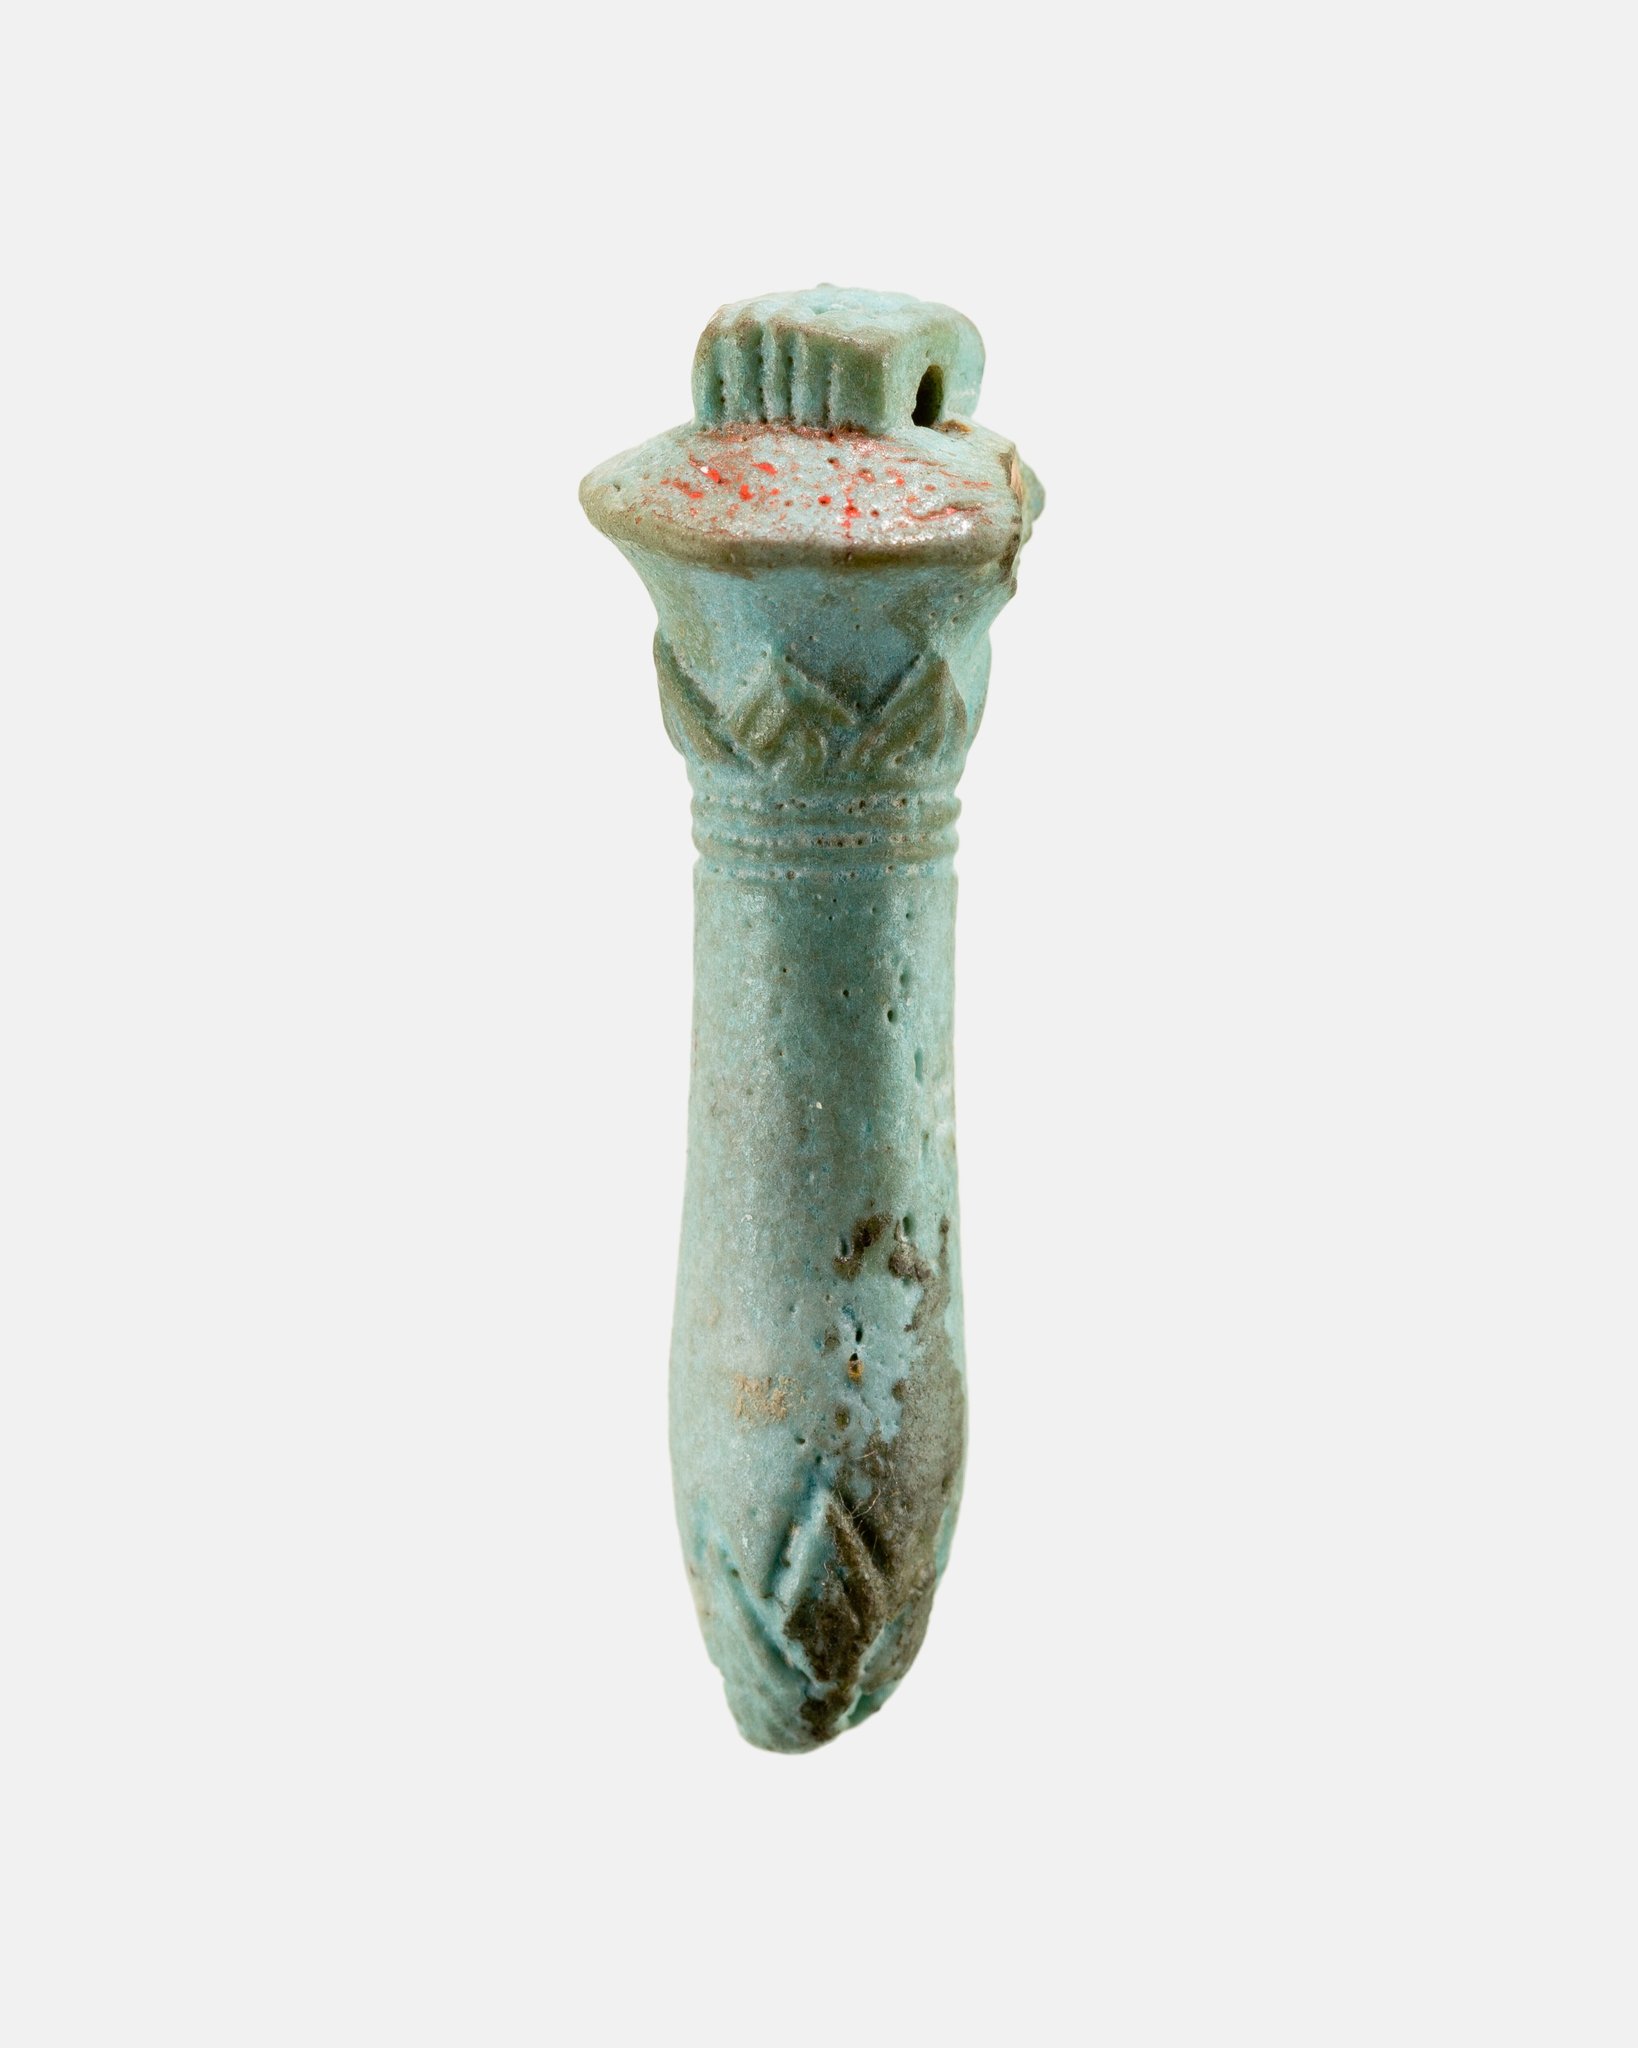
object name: amulet, papyrus column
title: Papyrus column (wadj) amulet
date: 664-332 BCE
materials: faience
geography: egypt